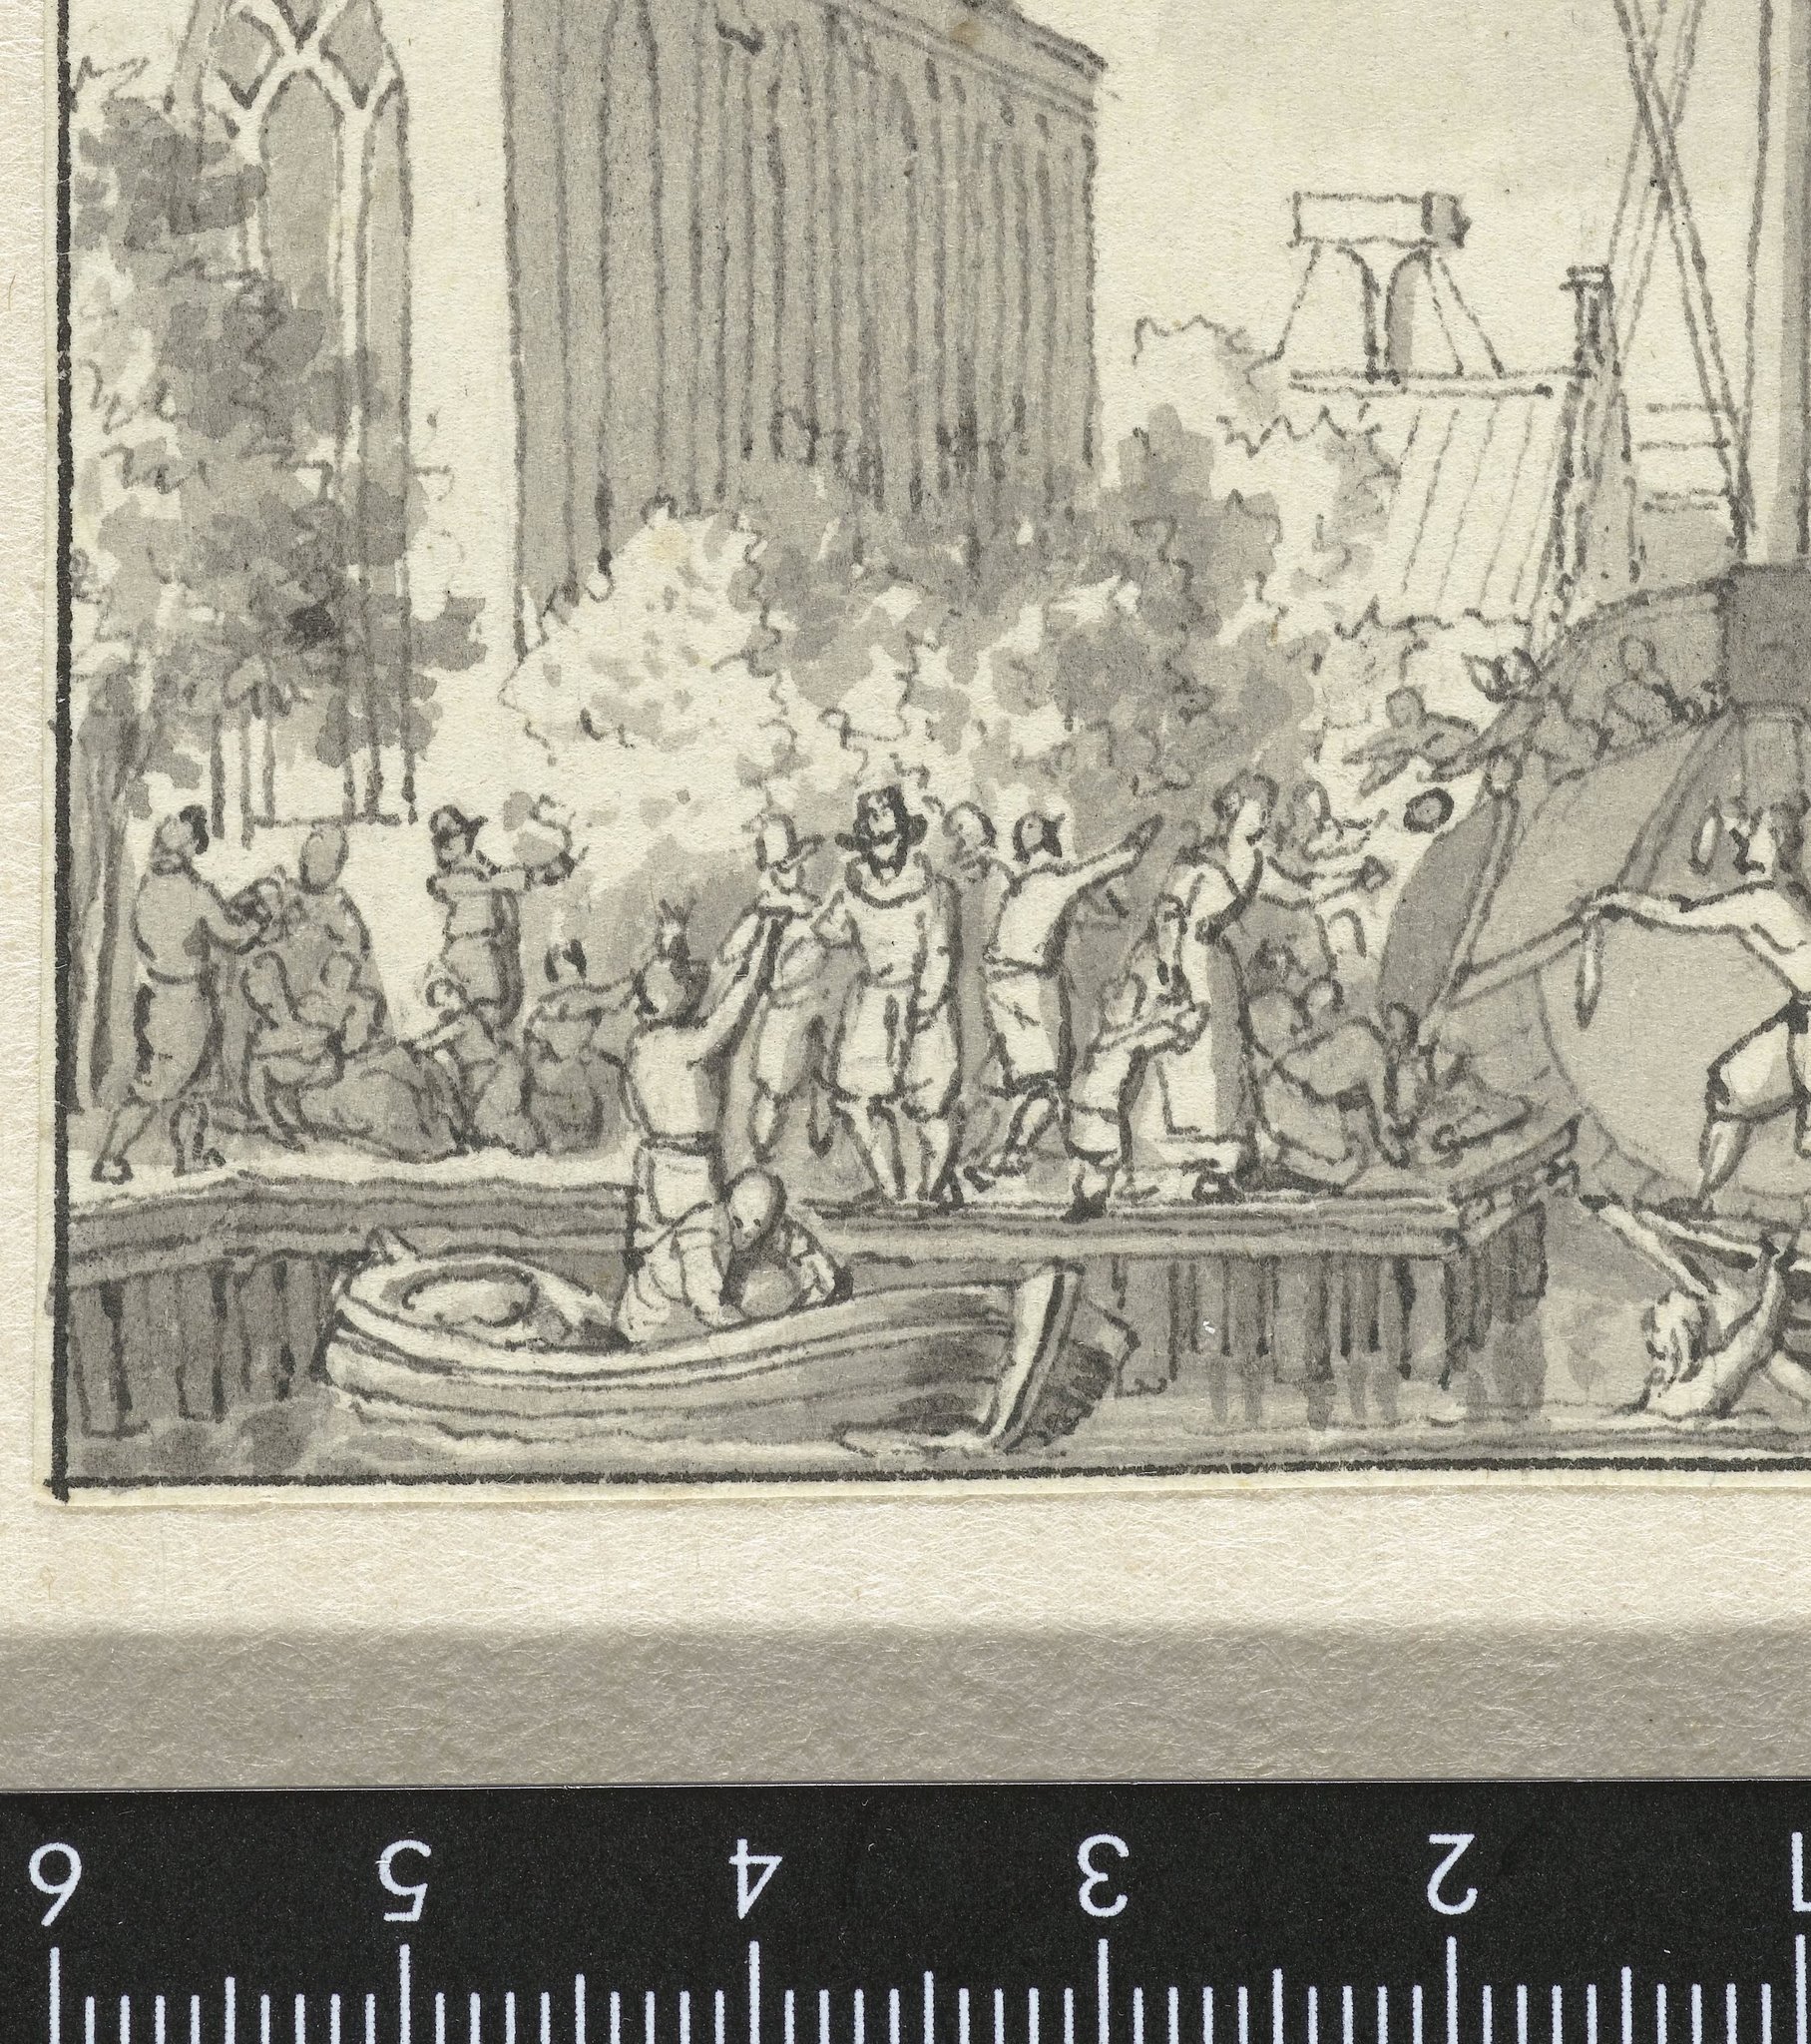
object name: design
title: In 't Jaar 1574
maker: Anonymous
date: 1789-1810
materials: ink, paper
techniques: brush, pen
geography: netherlands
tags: leiden